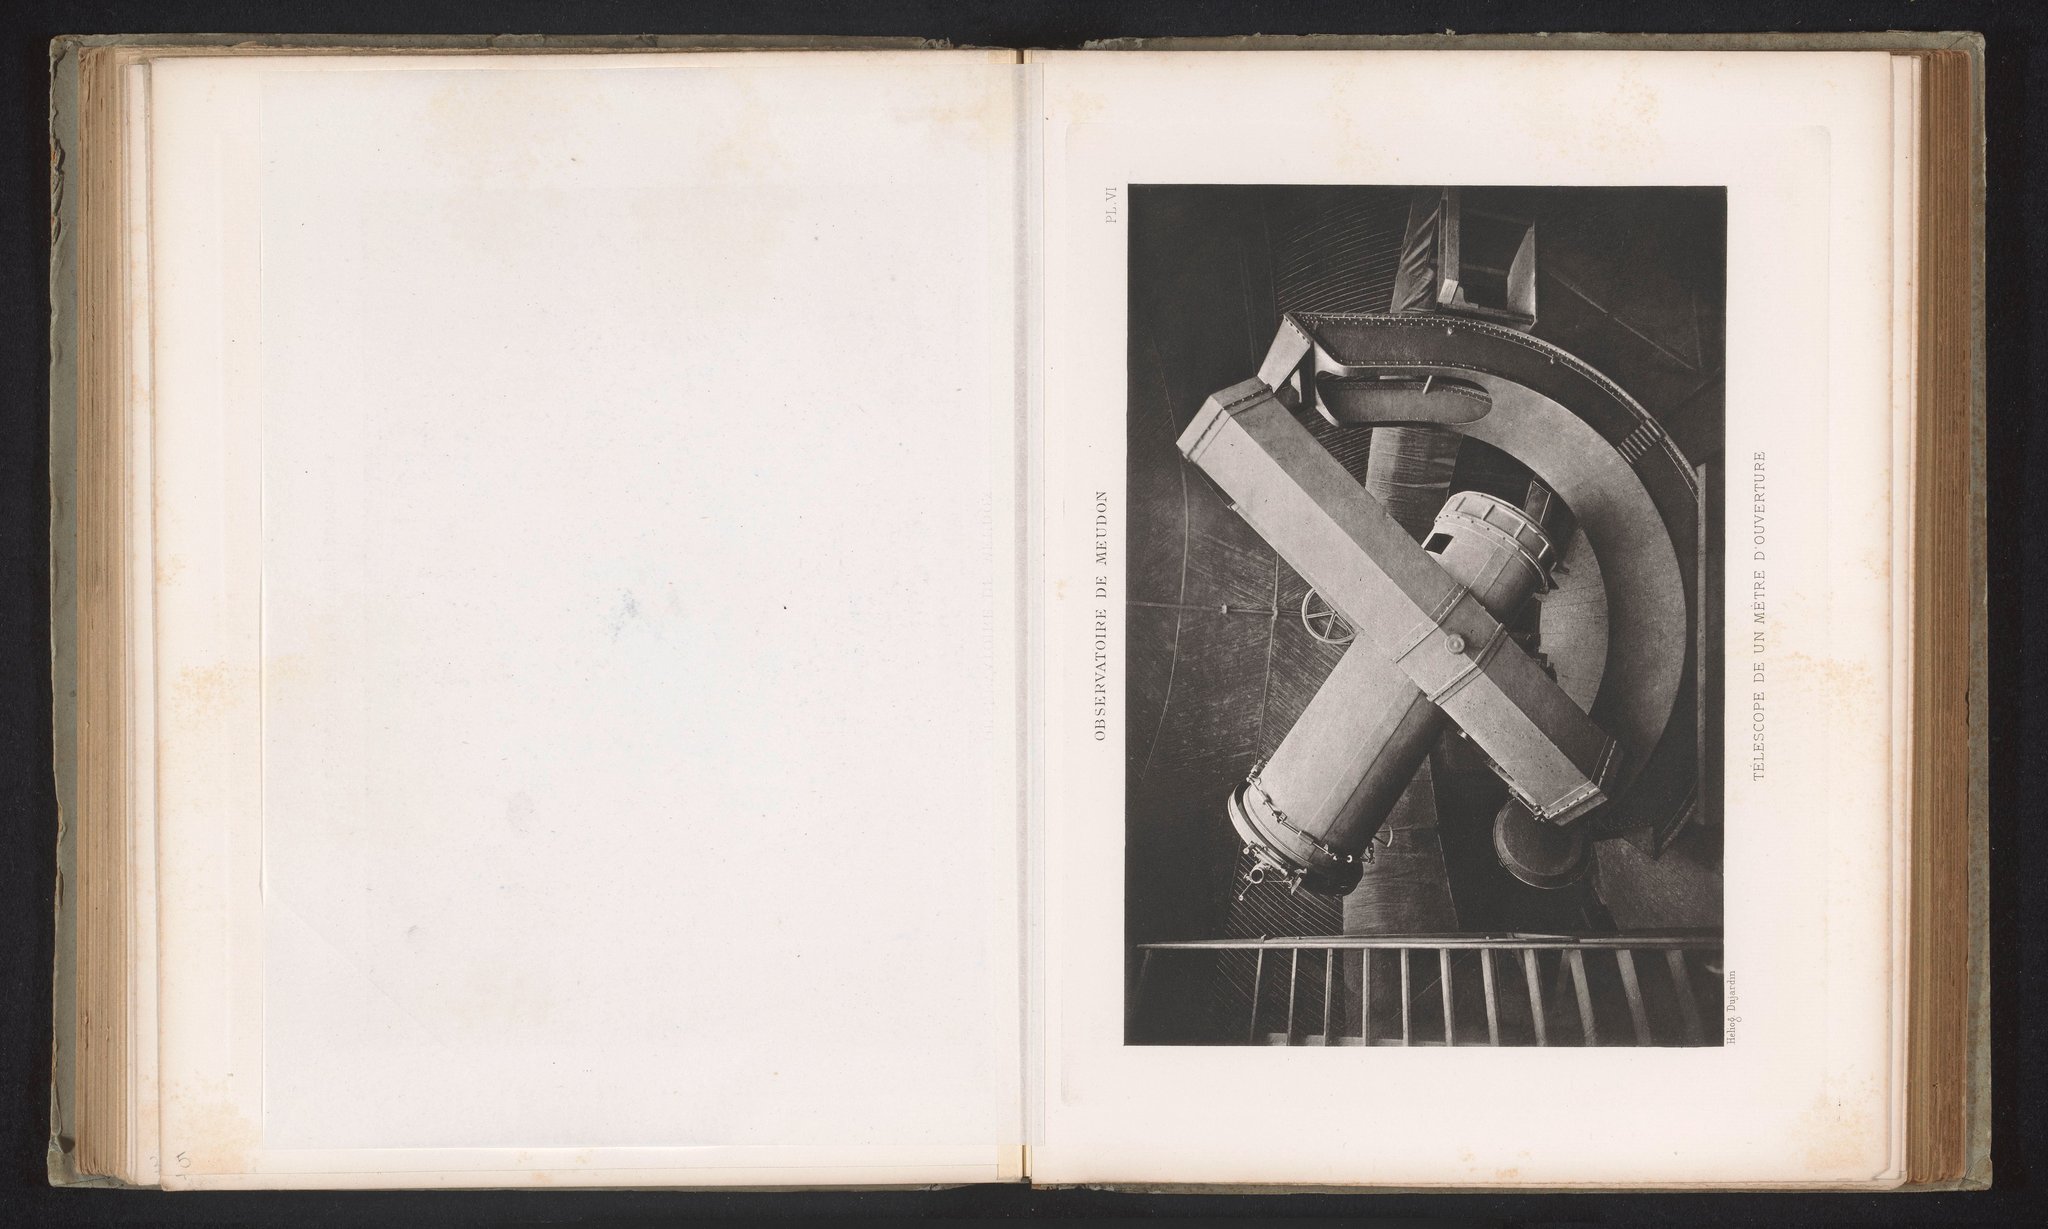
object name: photomechanical print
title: Telescoop met een diameter van één meter van het observatorium van Parijs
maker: dujardin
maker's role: printer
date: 1891-1896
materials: paper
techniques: photoaquatint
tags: telescope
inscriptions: inscription: ‘PL. VI’